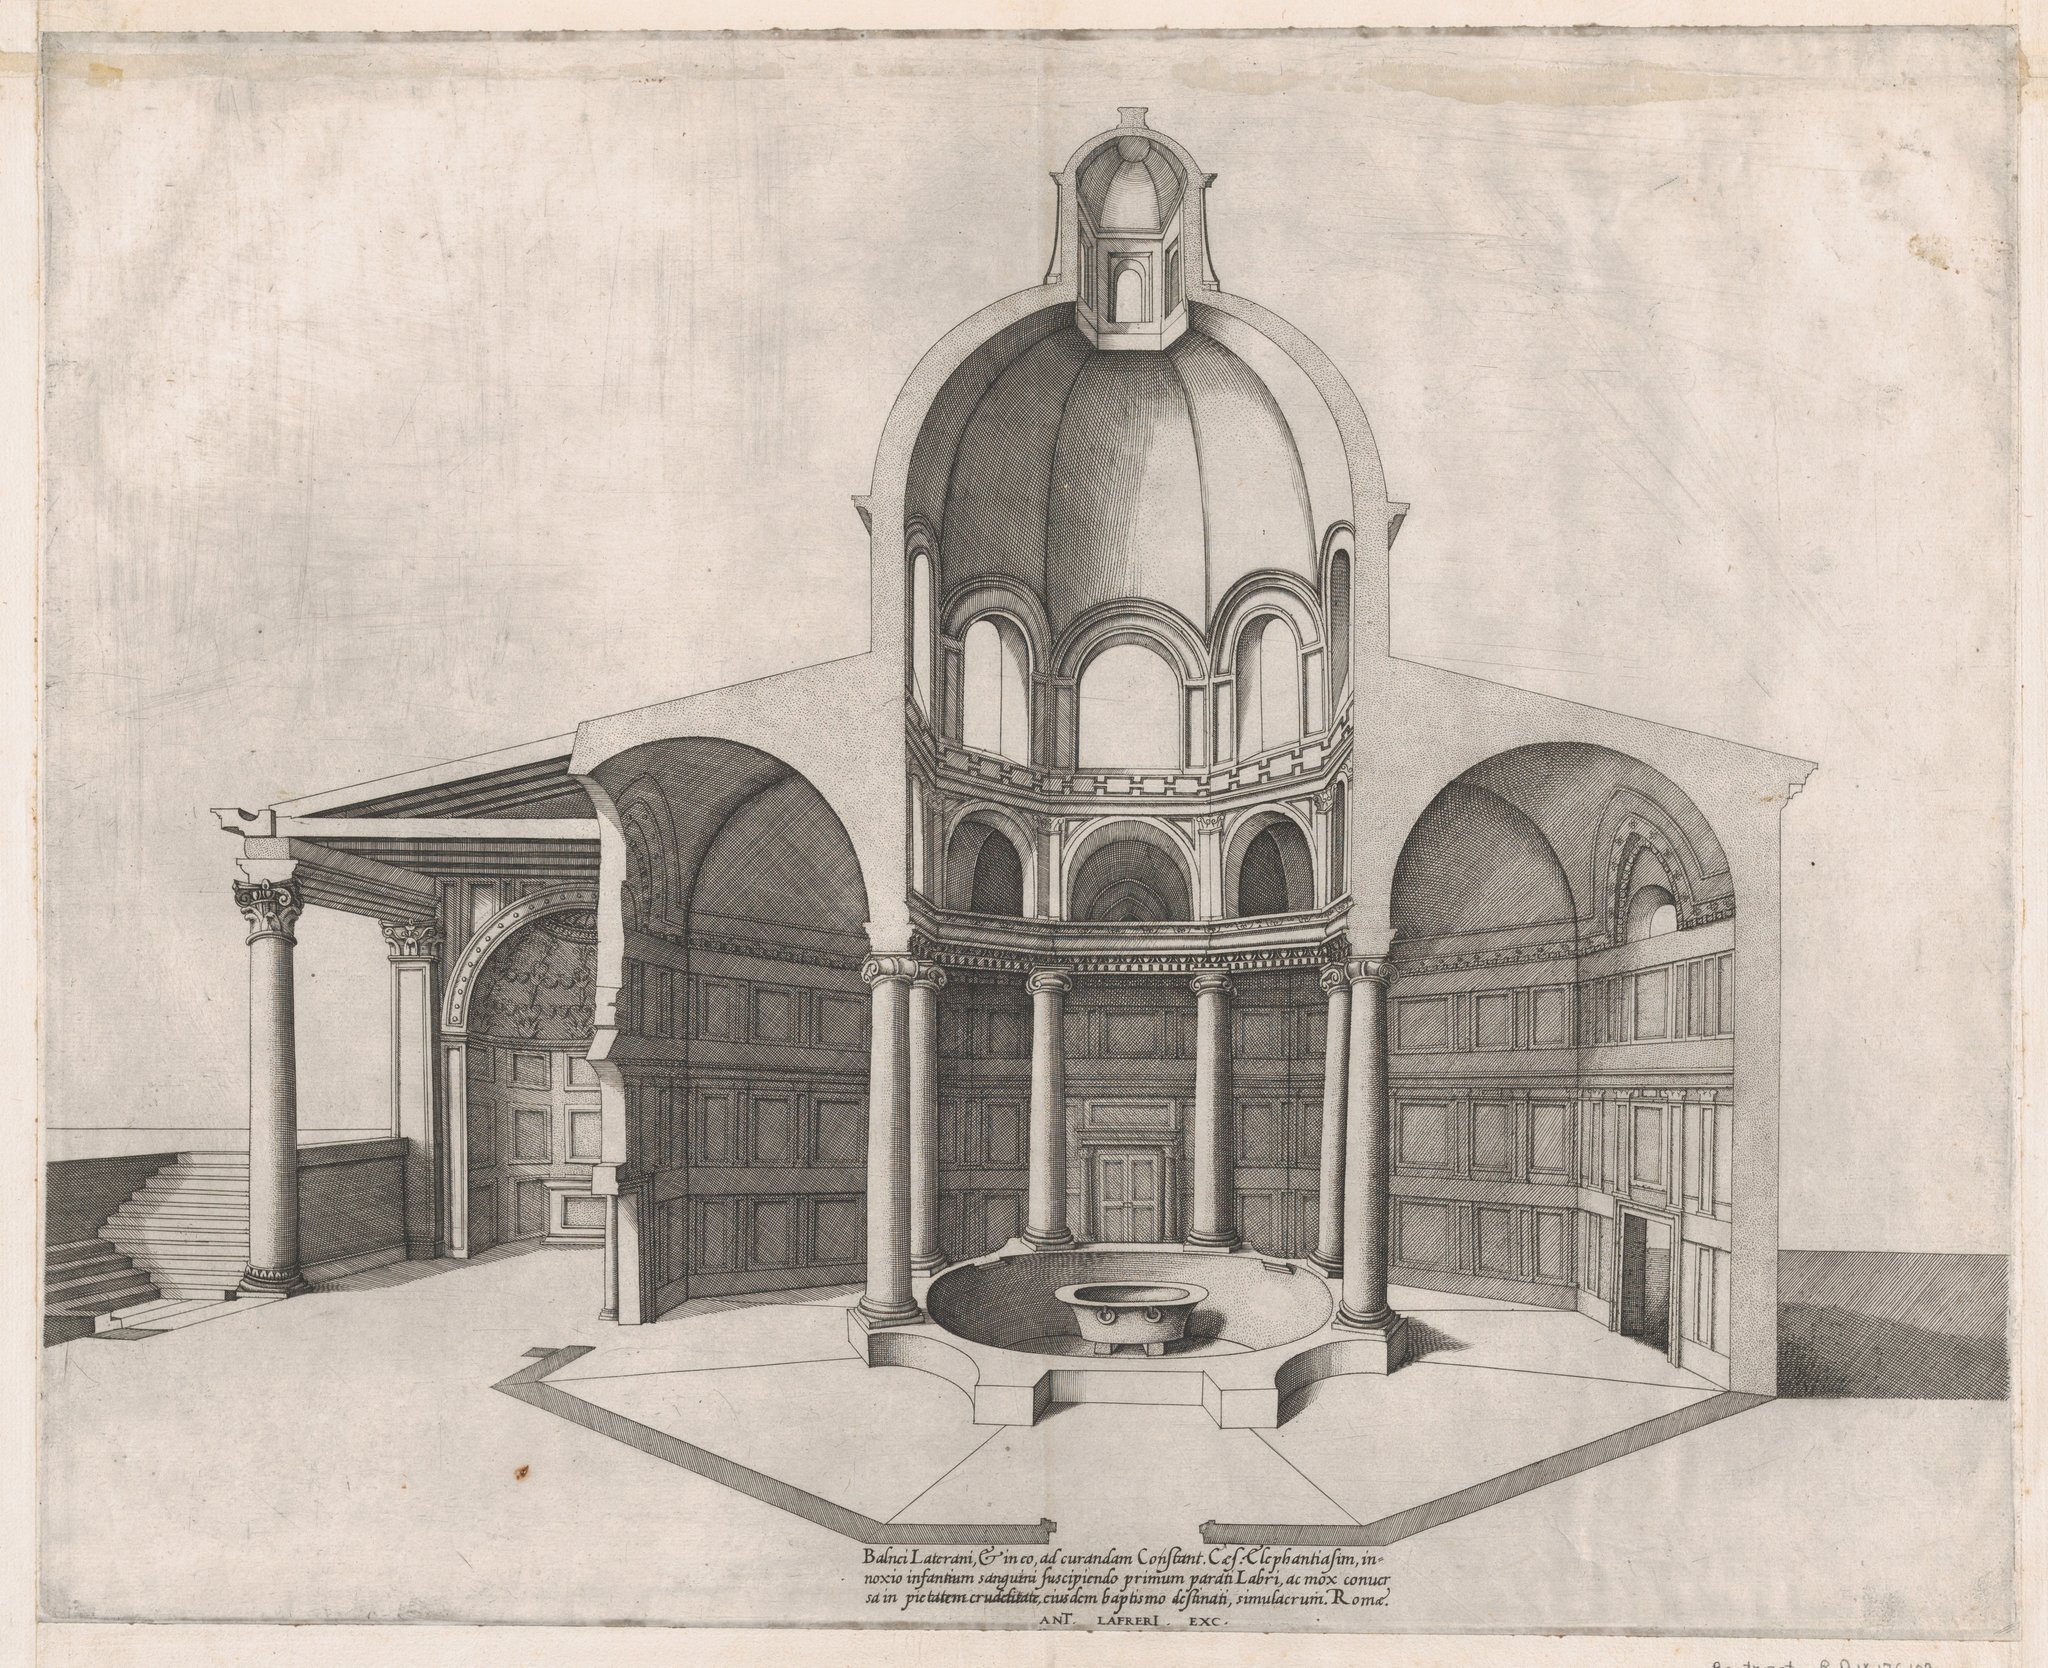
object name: print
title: Interior of the Lateran, from "Speculum Romanae Magnificentiae"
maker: nicolas beatrizet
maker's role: artist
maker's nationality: french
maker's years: 1515-1566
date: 1501-1600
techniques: engraving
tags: architecture,rome